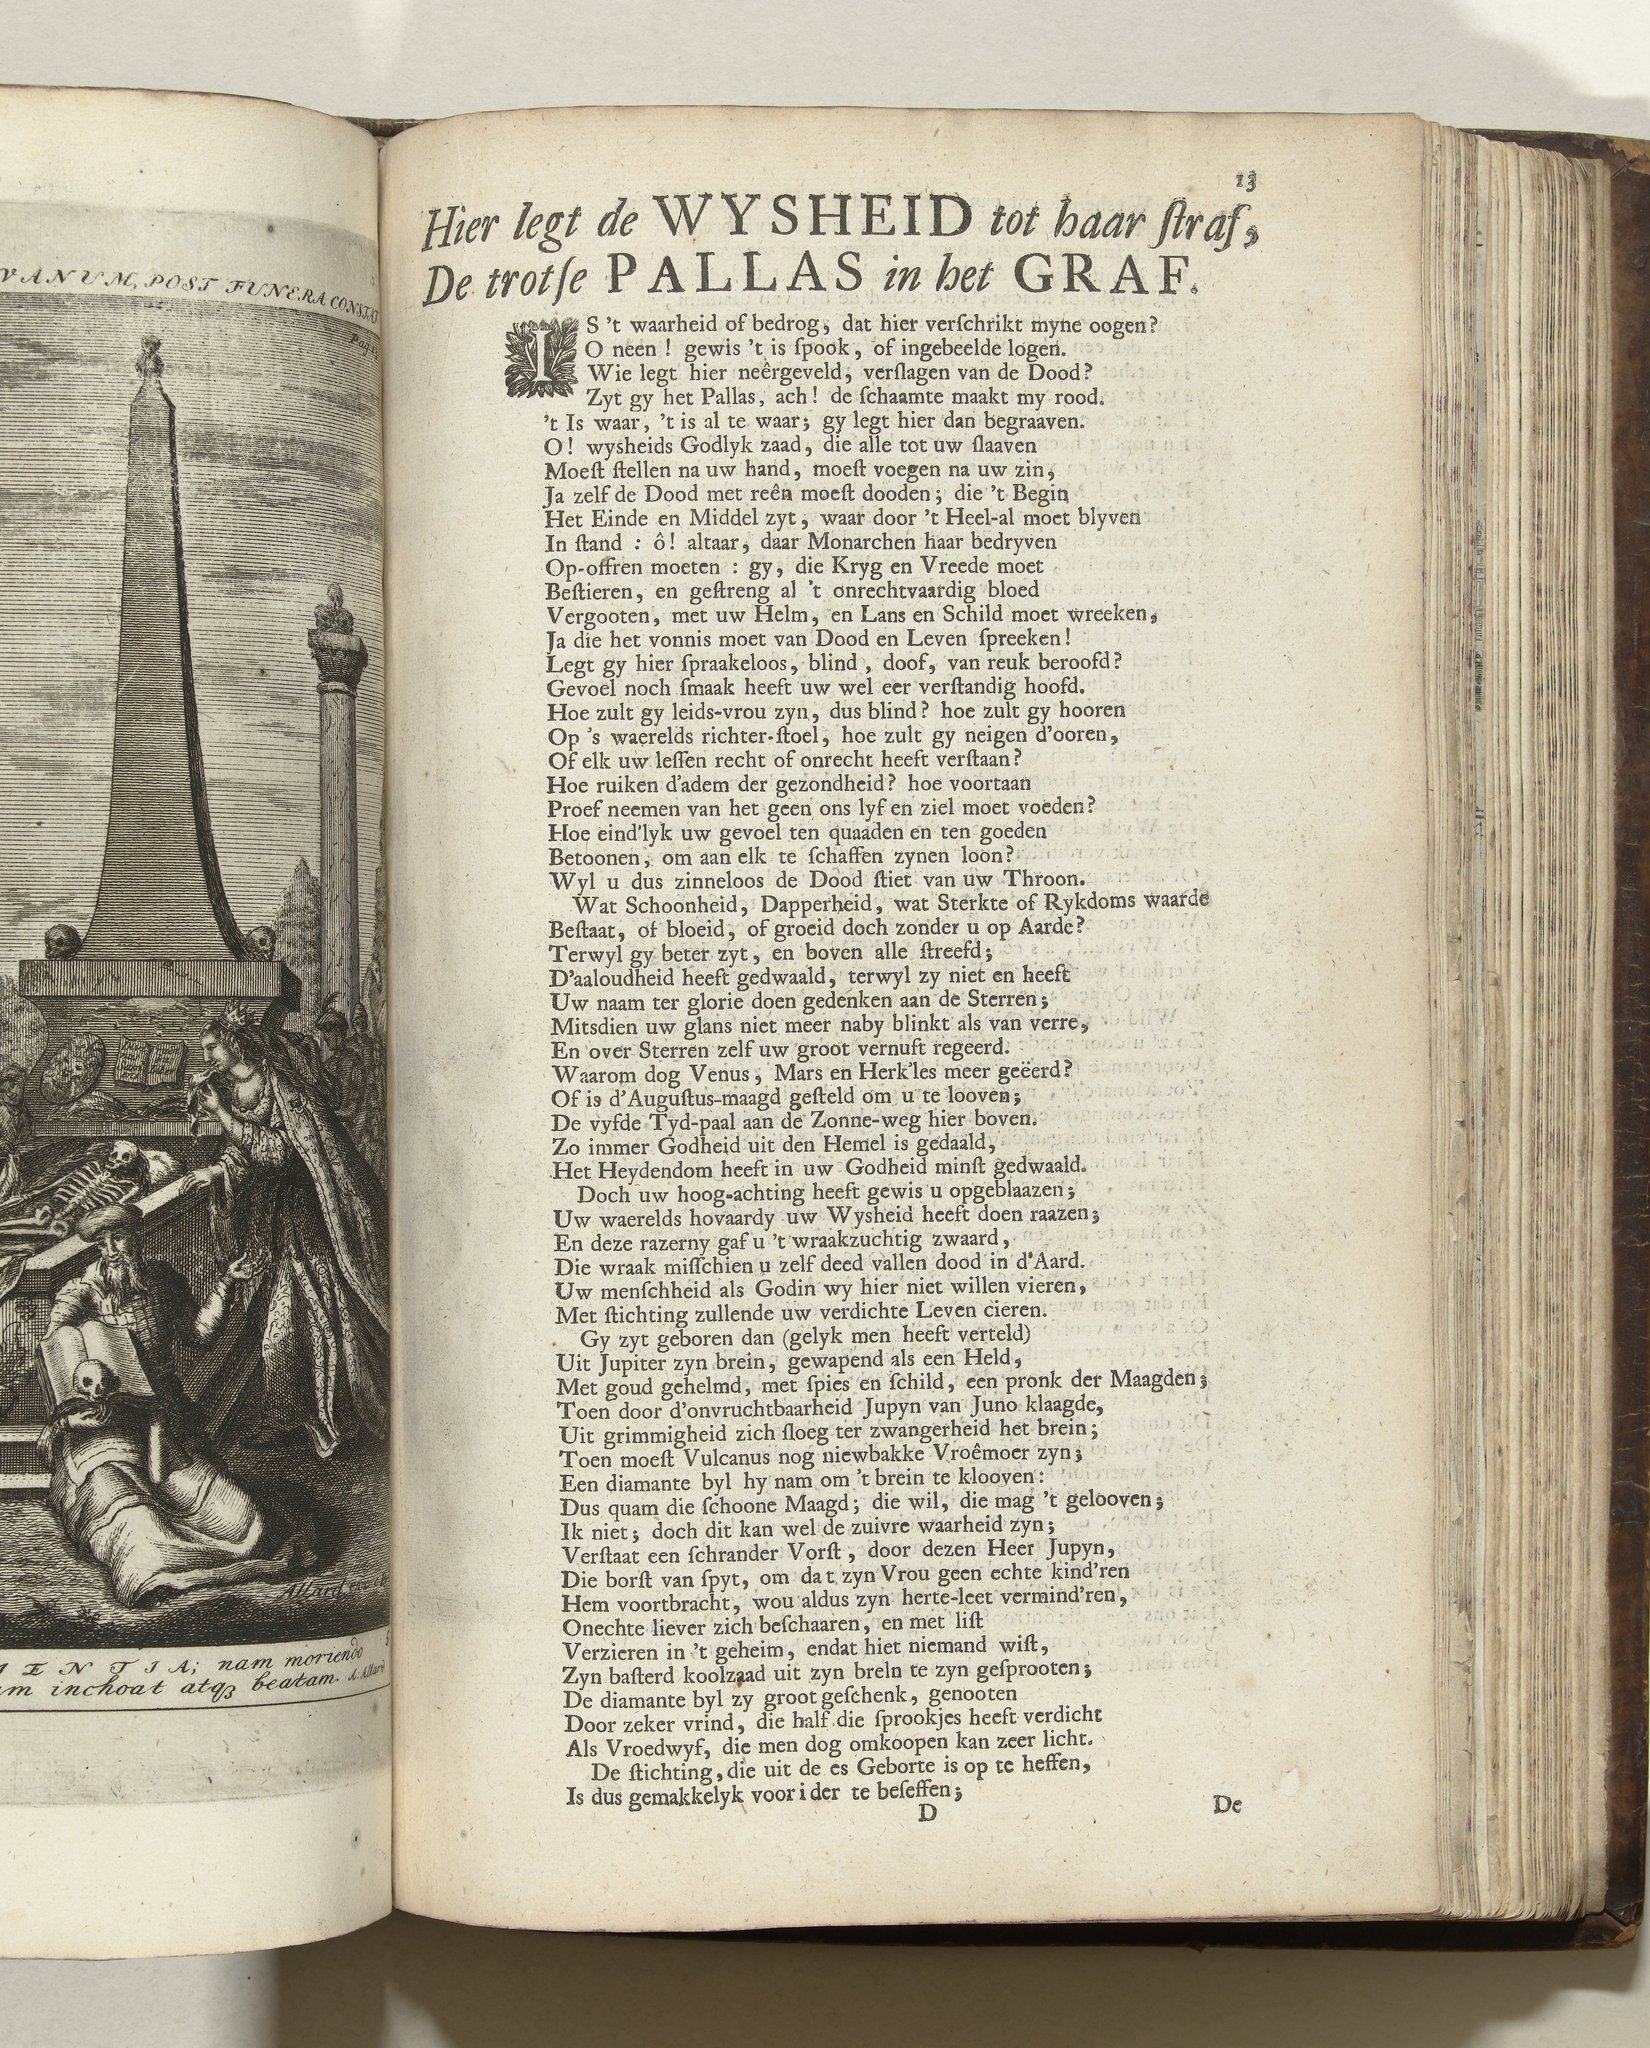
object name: text sheet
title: De Standvastige Monarchye des Doods / 't Lusthof van Momus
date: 1707-1708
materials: paper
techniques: letterpress printing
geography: amsterdam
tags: spaanse successieoorlog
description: Tekstblad met op beide bladzijden een vers behorend bij de prent met de allegorie waarin omstanders het geraamte in het geopende graf van de god Pallas (Minerva) bekijken, ca. 1707-1708. Onderdeel van: De Standvastige Monarchye des Doods, een reeks van 8 oude platen met verzen aangepast voor gebruik als spotprenten op de Fransen in de context van de Spaanse Successieoorlog. Onderdeel van het prentwerk uitgegeven onder de verzameltitel 't Lust-Hof van Momus met de gebundelde series van spotprenten tijdens de jaren 1701-1713 van de Spaanse Successieoorlog.